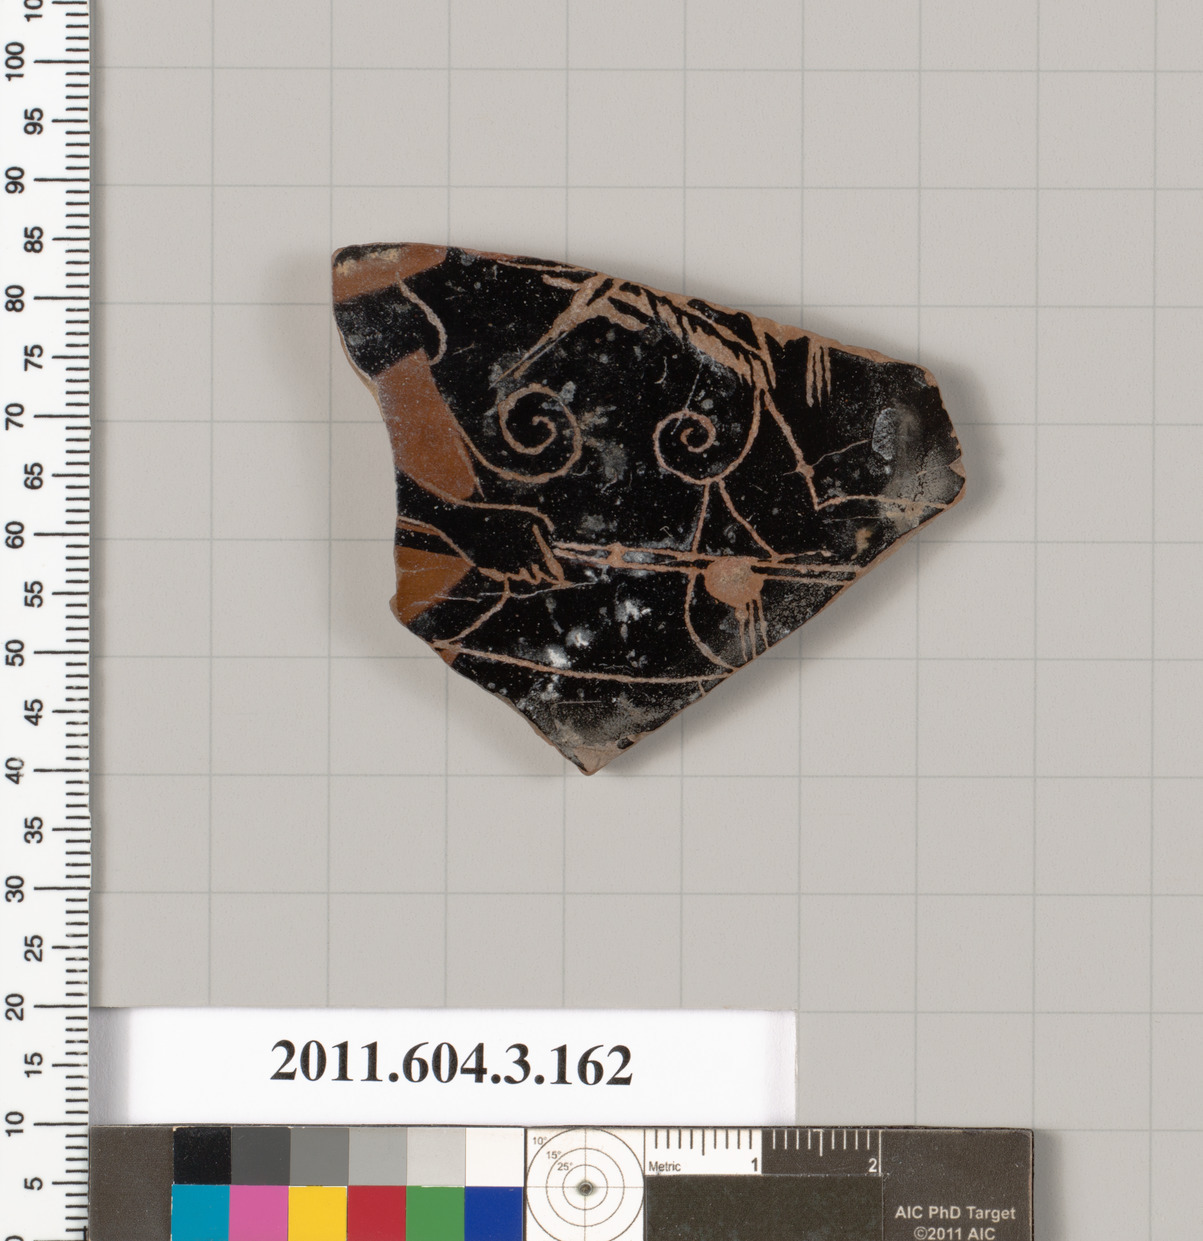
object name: amphora fragment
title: Terracotta fragment of an amphora (jar)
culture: greek, attic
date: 550-540 BCE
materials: terracotta